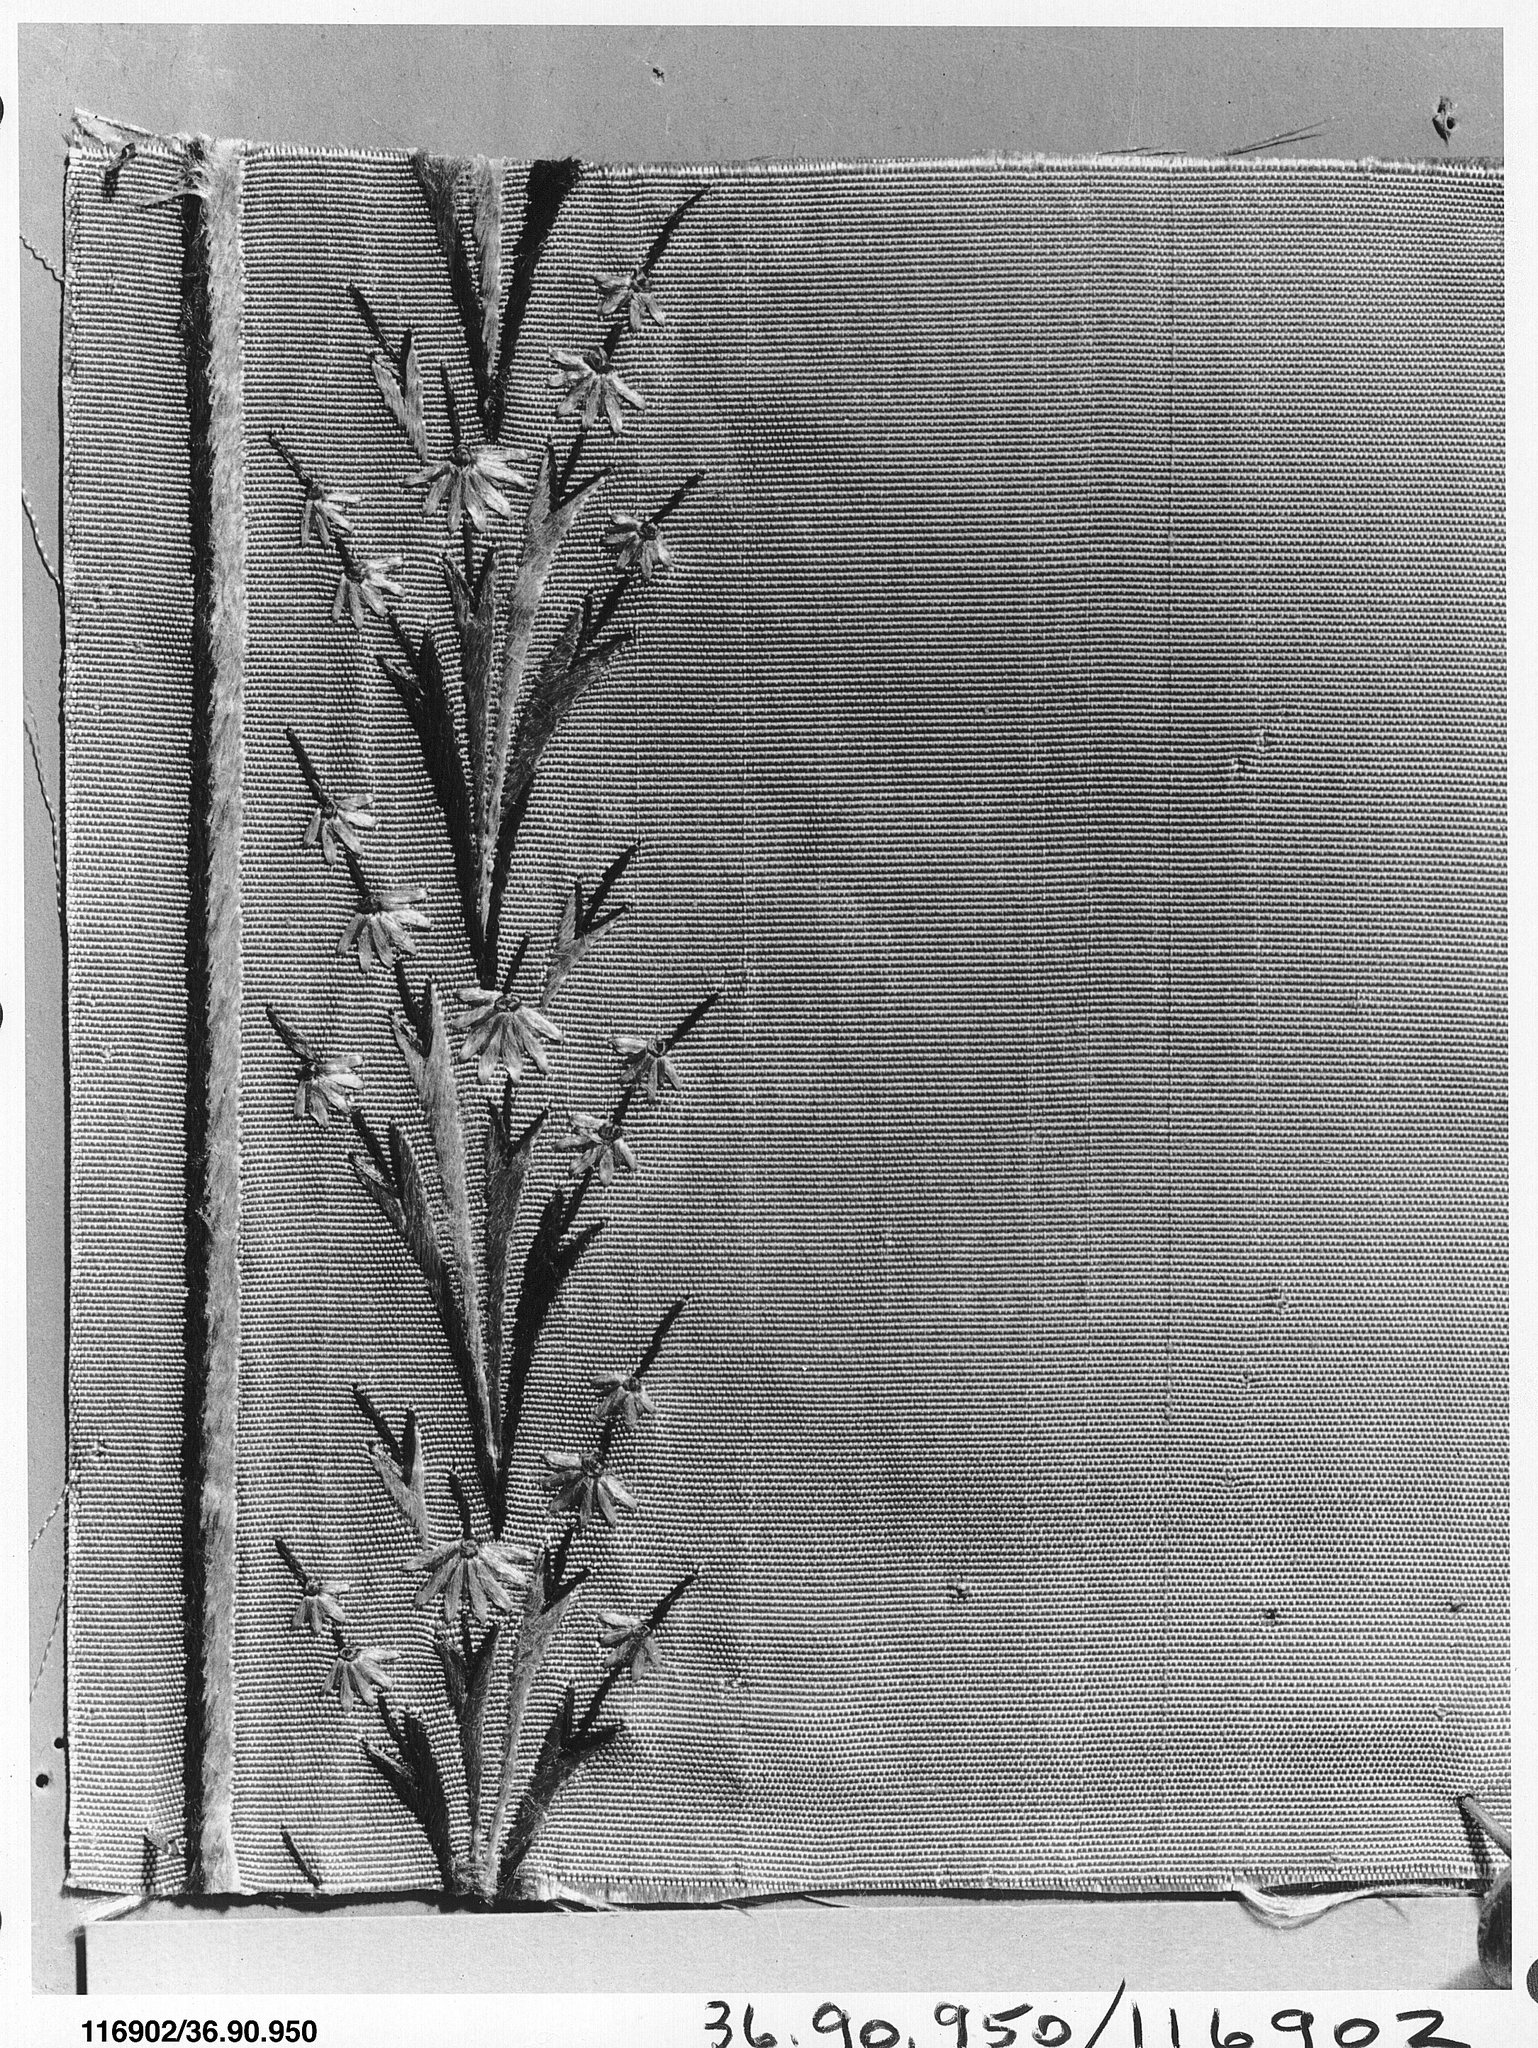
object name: sample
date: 1801-1833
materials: silk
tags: flowers